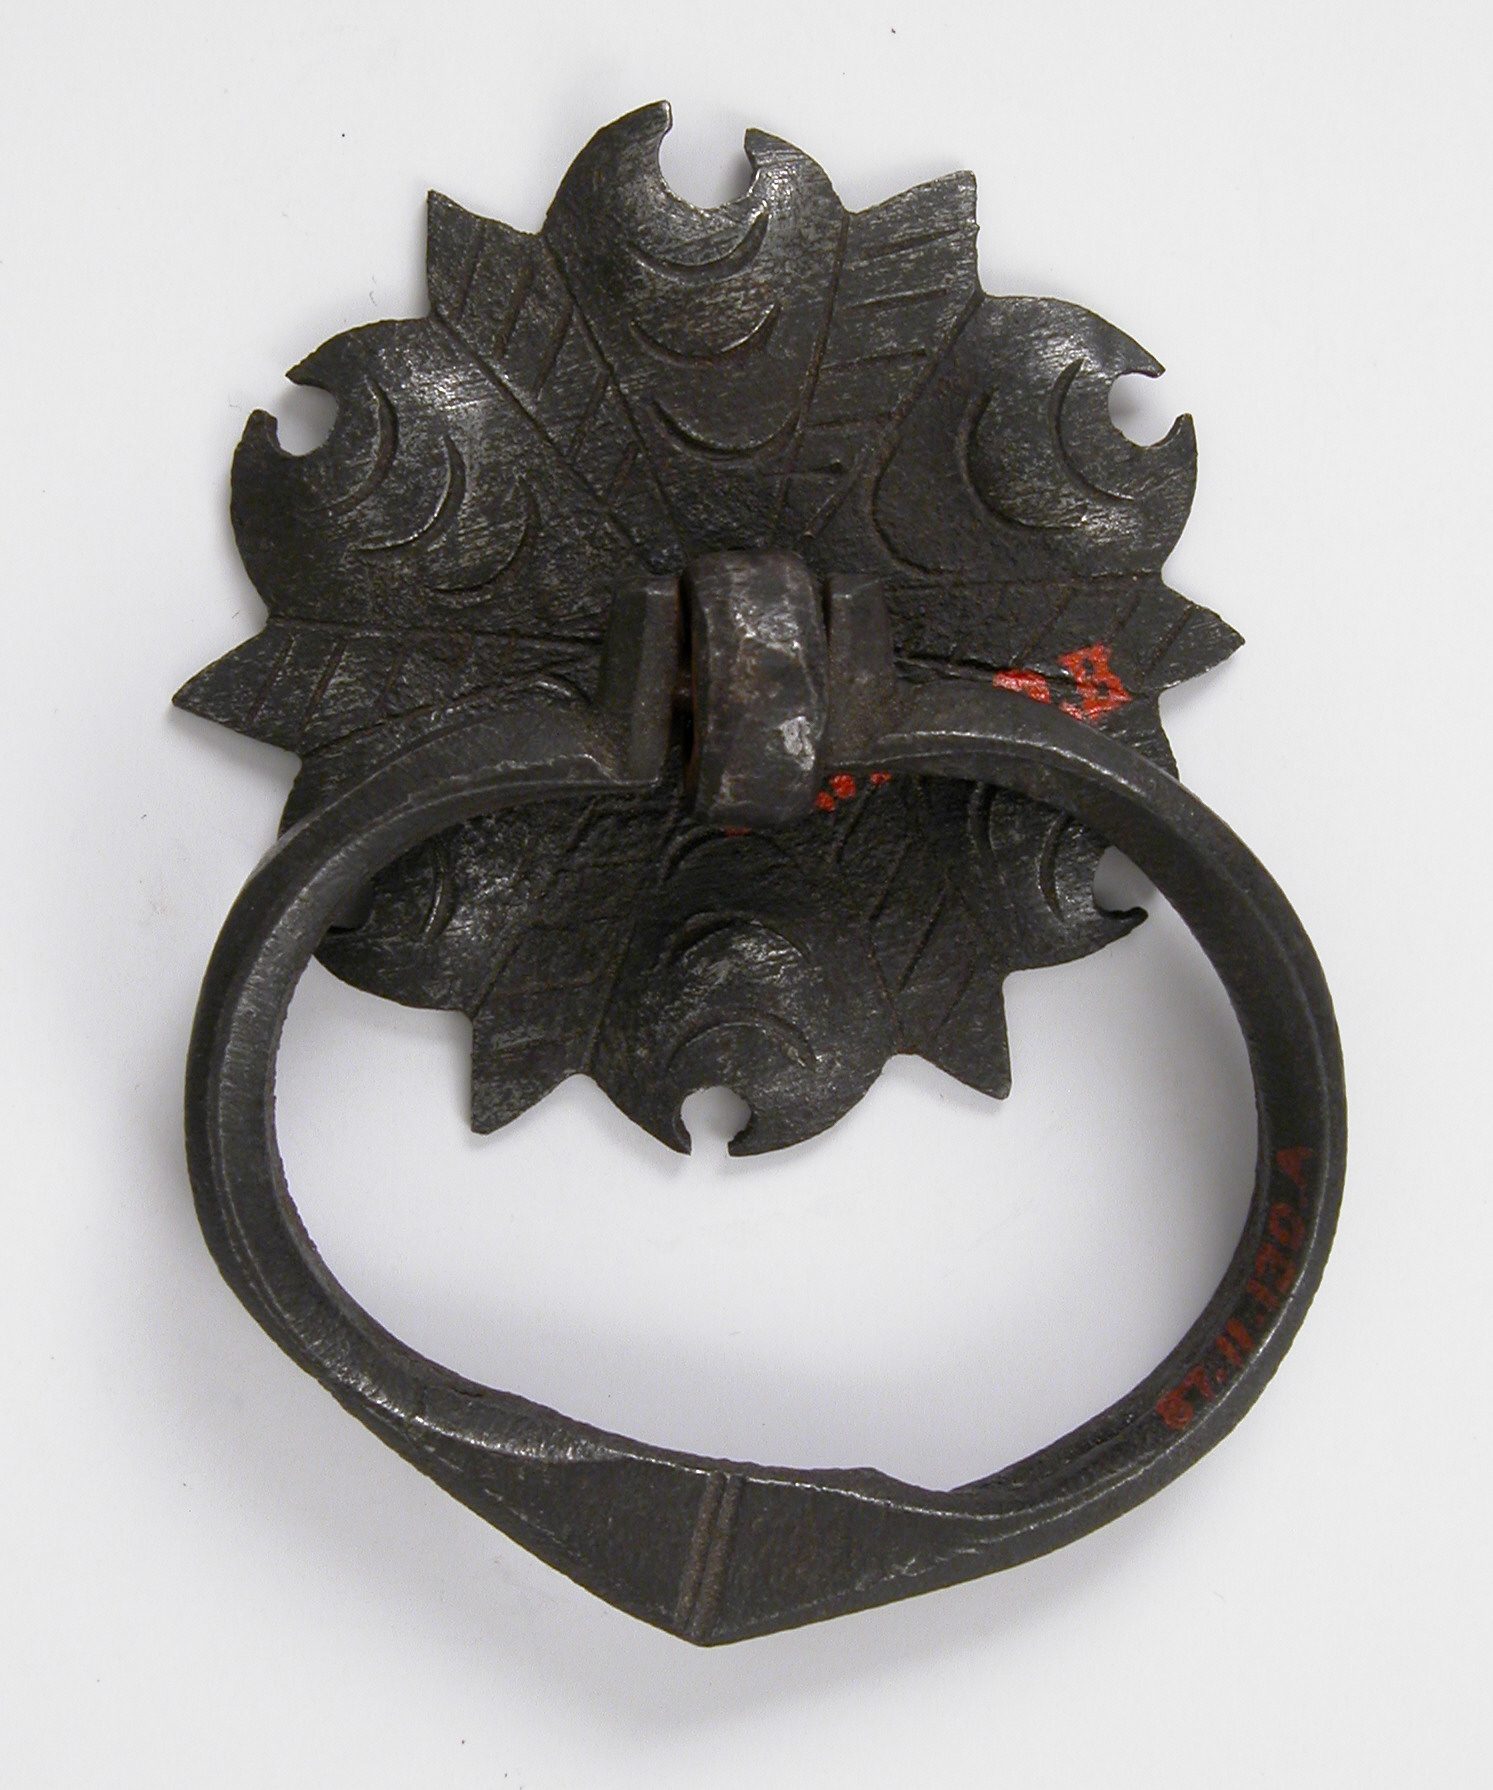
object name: door handle and plate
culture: german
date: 1501-1600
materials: iron